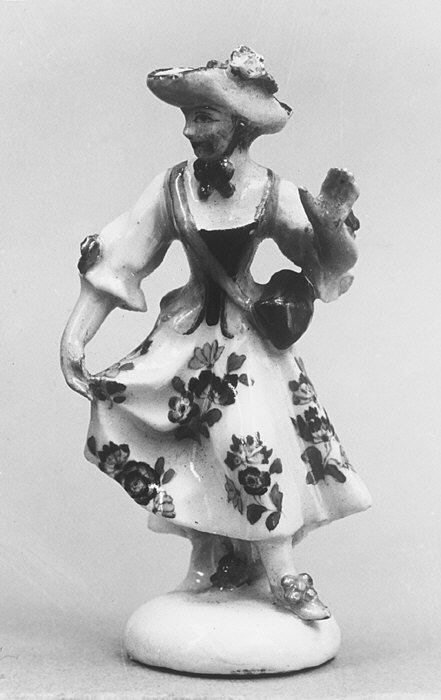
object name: figure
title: Figure of a woman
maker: meissen manufactory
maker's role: manufactory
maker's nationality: german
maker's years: 1710-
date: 1767-1800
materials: hard paste porcelain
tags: women,flowers